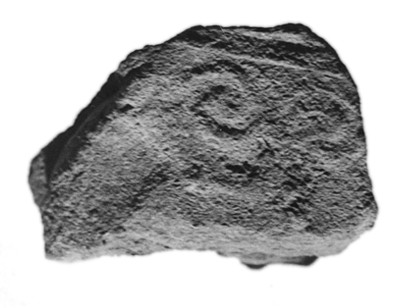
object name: sealing fragment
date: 2030-1640 BCE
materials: clay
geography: egypt